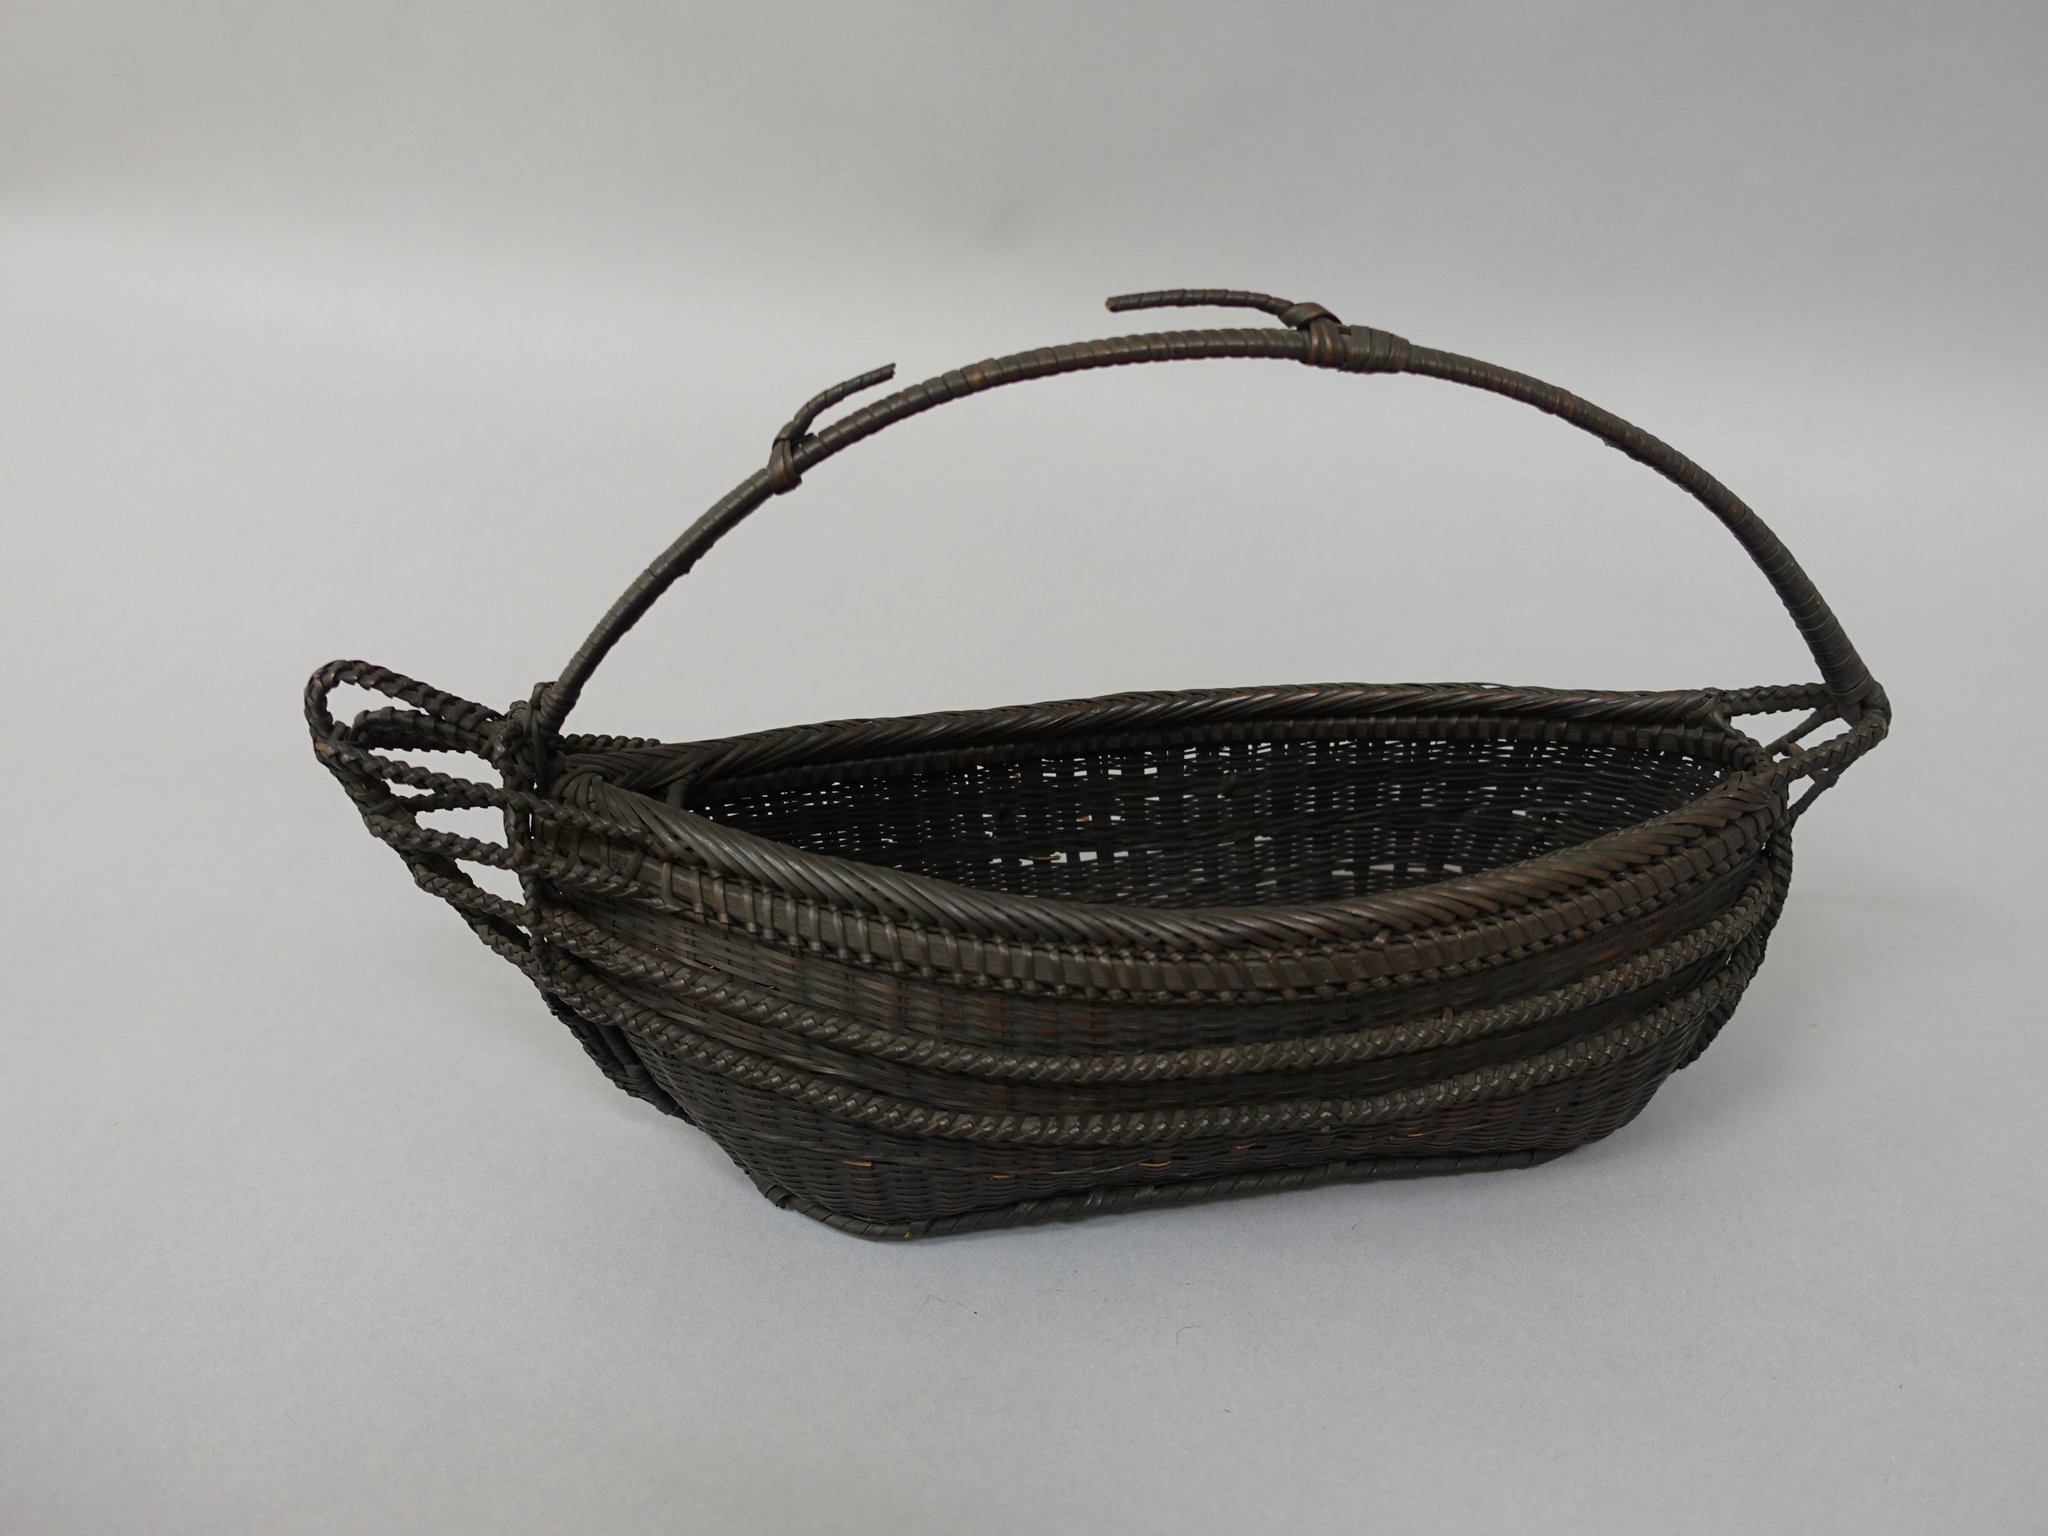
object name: basket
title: Boat-Shaped Basket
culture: japanese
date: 1801-1900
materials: bamboo